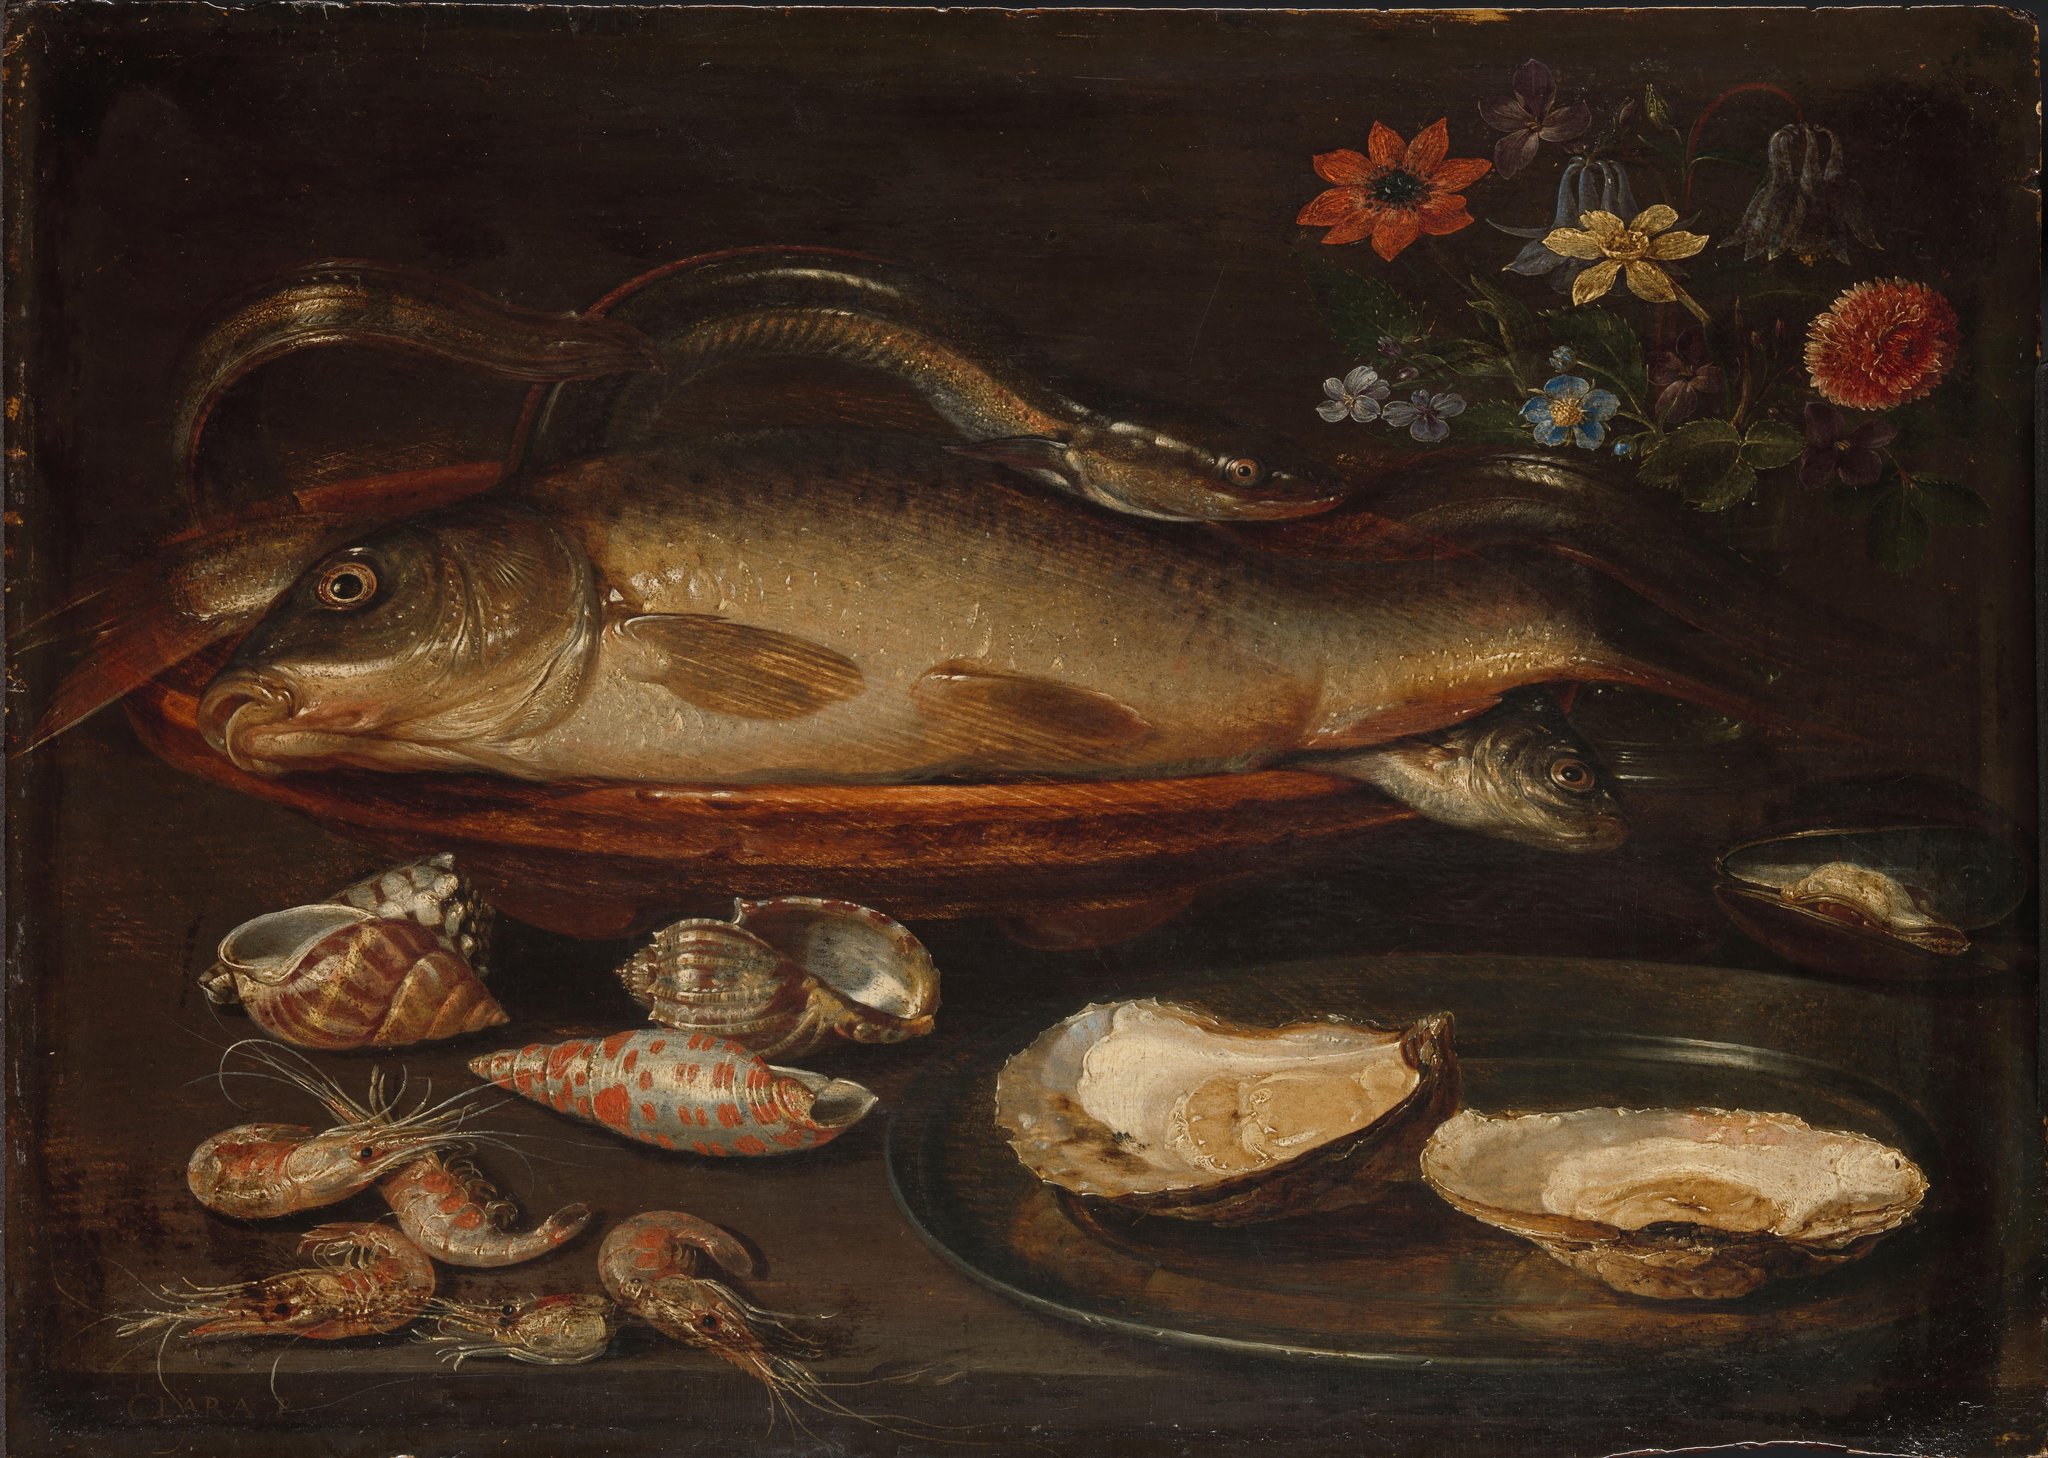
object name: painting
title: Still Life with Fish, Sea Food and Flowers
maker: clara peeters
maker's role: painter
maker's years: 1580-1634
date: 1612-1615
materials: oil, panel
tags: seafood, molluscs (+ shell, snail-shell etc.), fish; still life of fishes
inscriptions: signature, bottom left, on the table edge: ‘CLARA P.’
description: The gleaming carp, the slippery eel, and the shiny glaze of the earthenware bowl: they seem almost tangible. With her still lifes, Peeters seamlessly tapped into the era’s fascination with plants, flowers, and ‘art cabinets’ in which wealthy collectors gathered special objects. In this instance, she combines fish, shells, and oysters from all over the world.